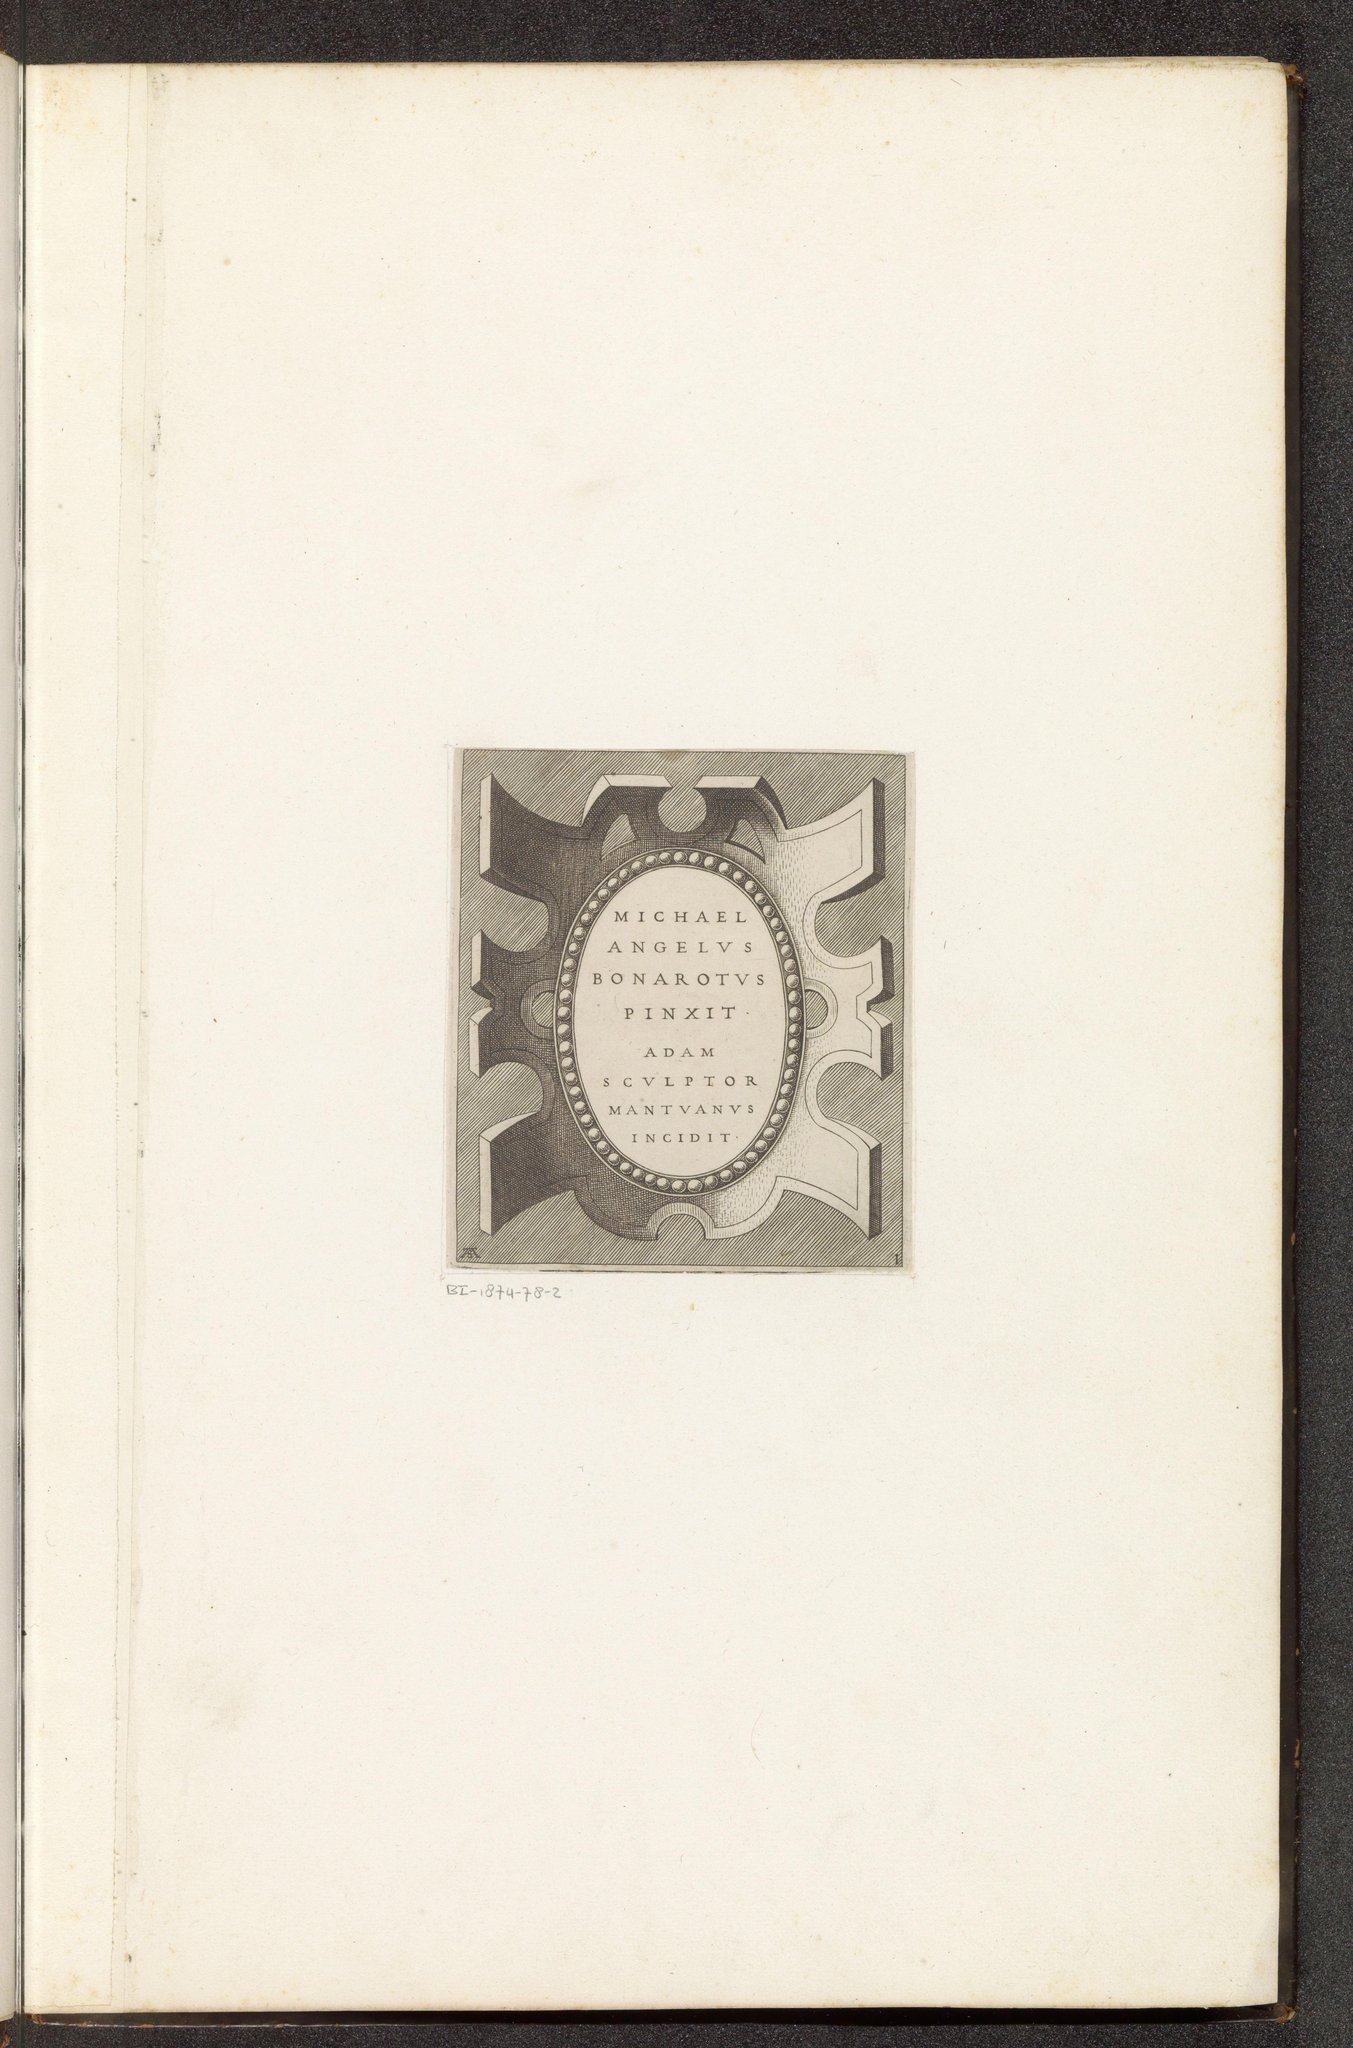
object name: album leaf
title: Schilderingen in de Sixtijnse kapel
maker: adamo scultori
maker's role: painter, print maker, sculptor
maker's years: 1530-1585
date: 1585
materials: paper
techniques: engraving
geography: italy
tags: ornament ~ cartouche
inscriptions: collector's mark: Lugt 2166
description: Titelprent van een serie die behalve de titelprent bestaat uit 72 prenten naar schilderingen door Michelangelo in de Sixtijnse Kapel in het Vaticaan.